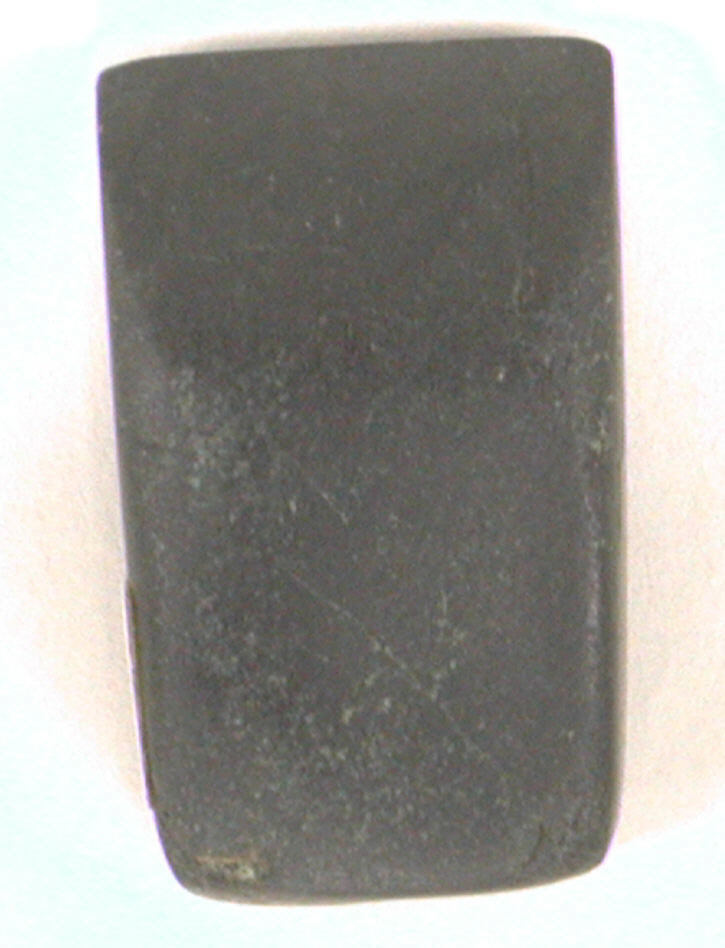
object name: chisel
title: Stone Chisel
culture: mexican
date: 1501-1600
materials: stone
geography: mexico